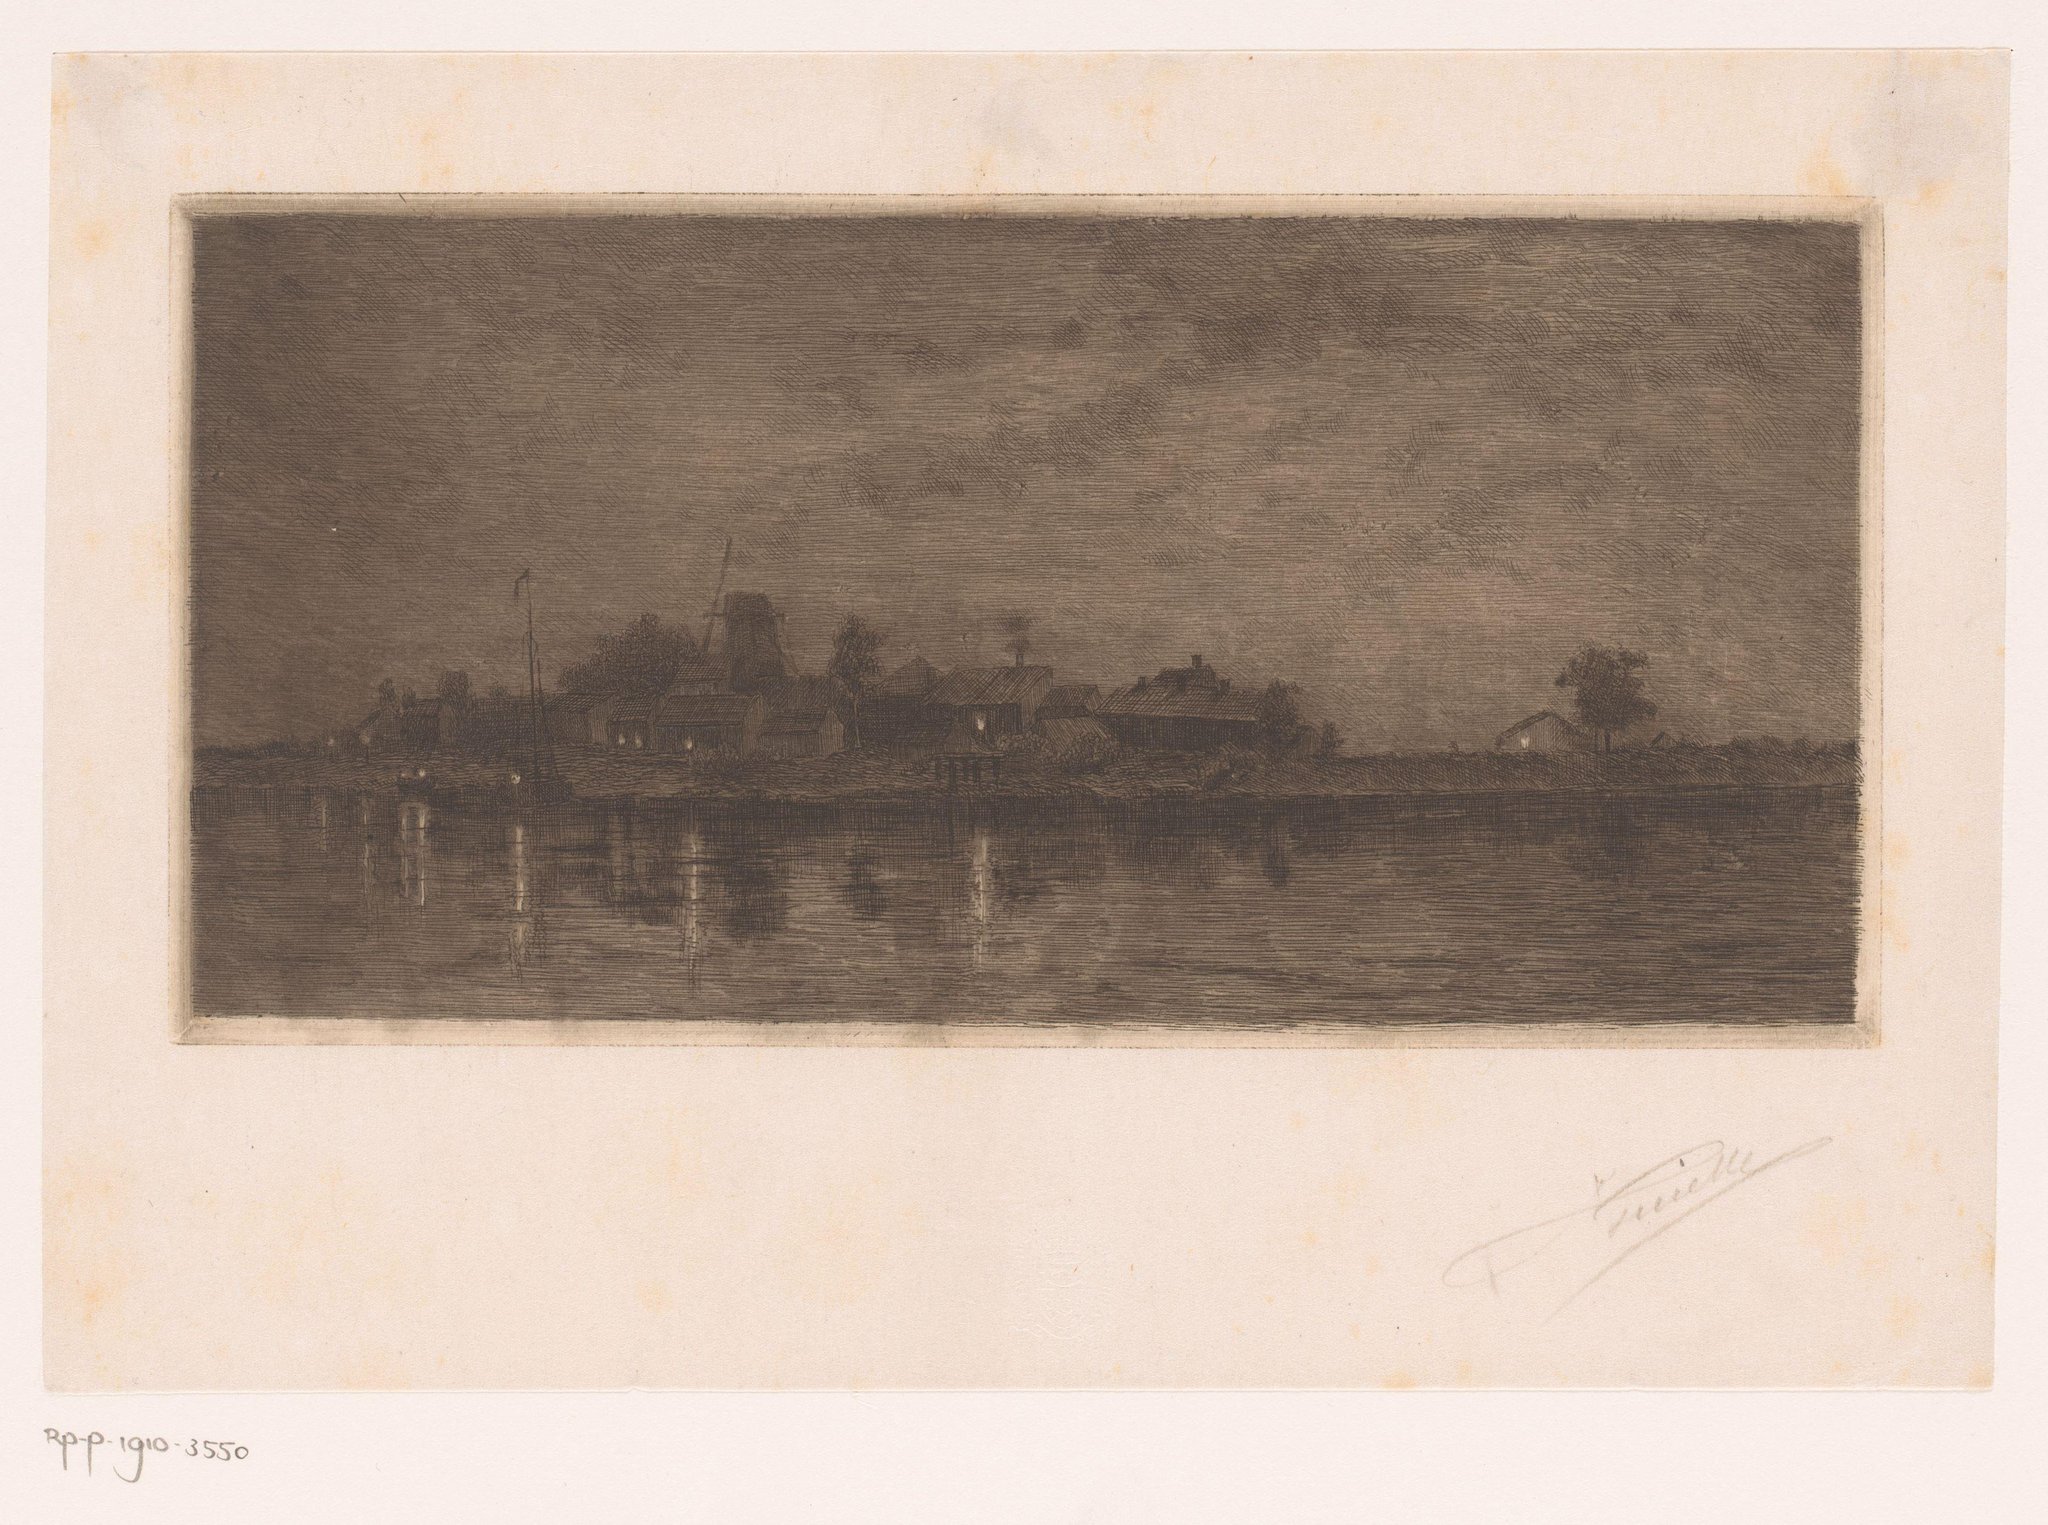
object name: print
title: Gezicht op een dorp aan een rivier in de avond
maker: jules guiette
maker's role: print maker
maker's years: 1852-1901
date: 1862-1901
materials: paper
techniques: etching, intaglio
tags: prospect of village, silhouette of village, river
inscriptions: collector's mark: Lugt 2228, workshop stamp: ‘Antwerpsche Etsers 1880’